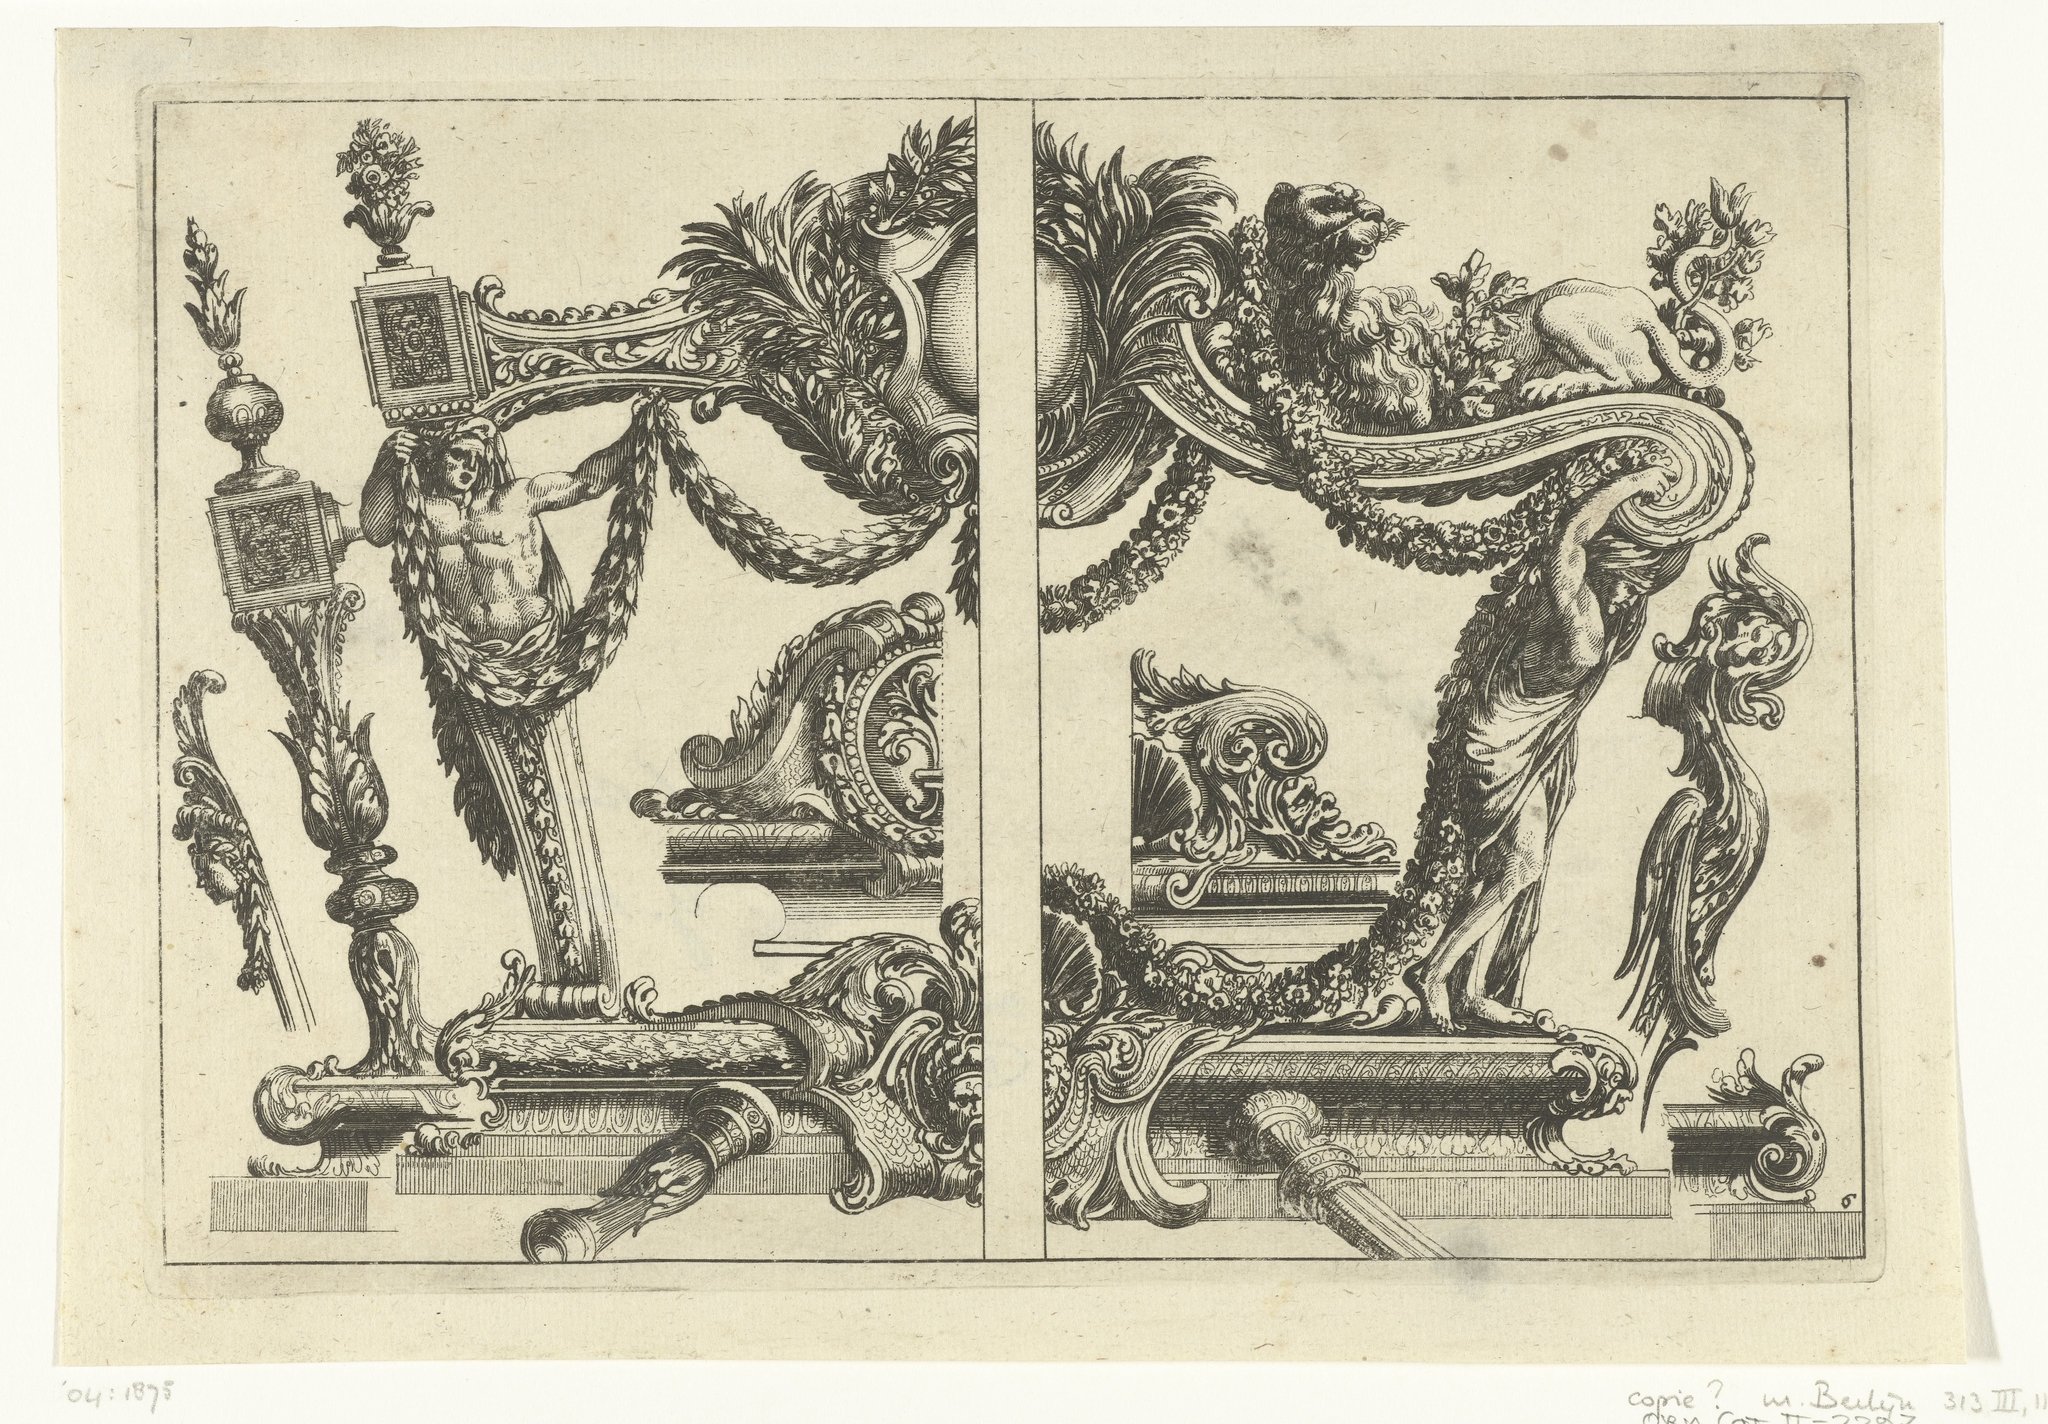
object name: ornament print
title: New Designs for Ornamenting and Embellishing Coaches and Carriages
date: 1680-1701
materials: paper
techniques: etching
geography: netherlands